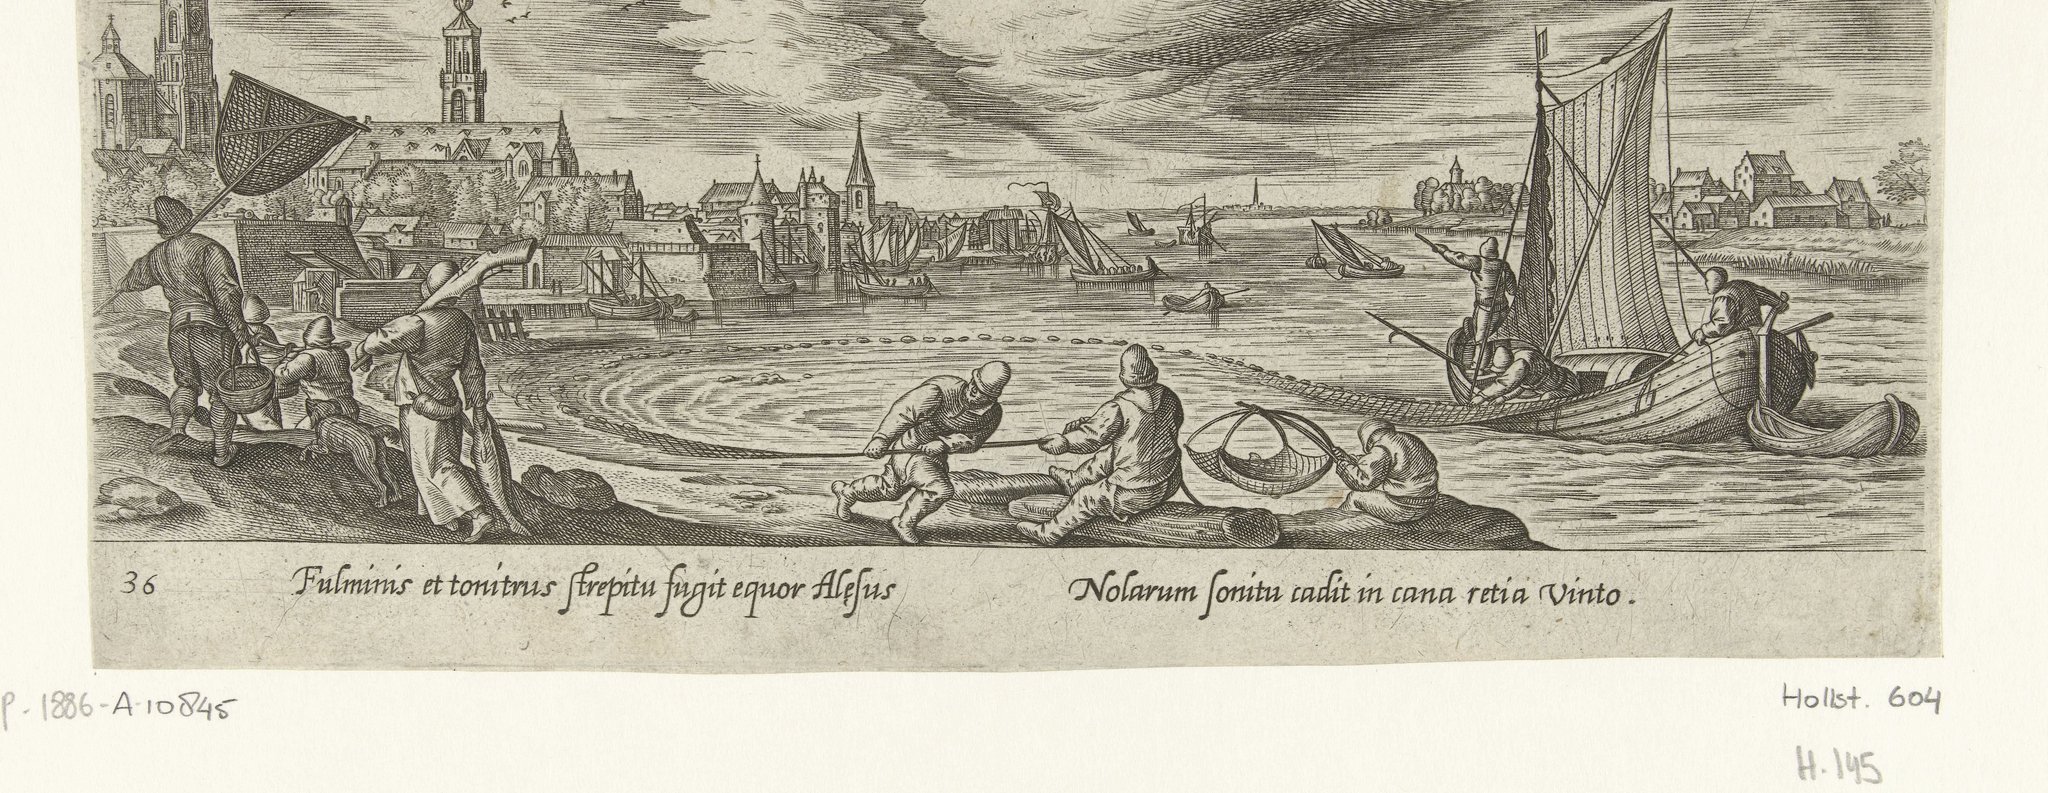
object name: print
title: Jacht en visvangst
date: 1582-1633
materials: paper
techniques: engraving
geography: antwerp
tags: fresh-water fishery (+ aids ~ crafts, industries, agriculture)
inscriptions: collector's mark: Lugt 2228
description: In een rivier wordt vis gevangen door middel van een bolvormig net en een sleepnet. De prent heeft een Latijns onderschrift en maakt deel uit van een serie van 54 prenten.